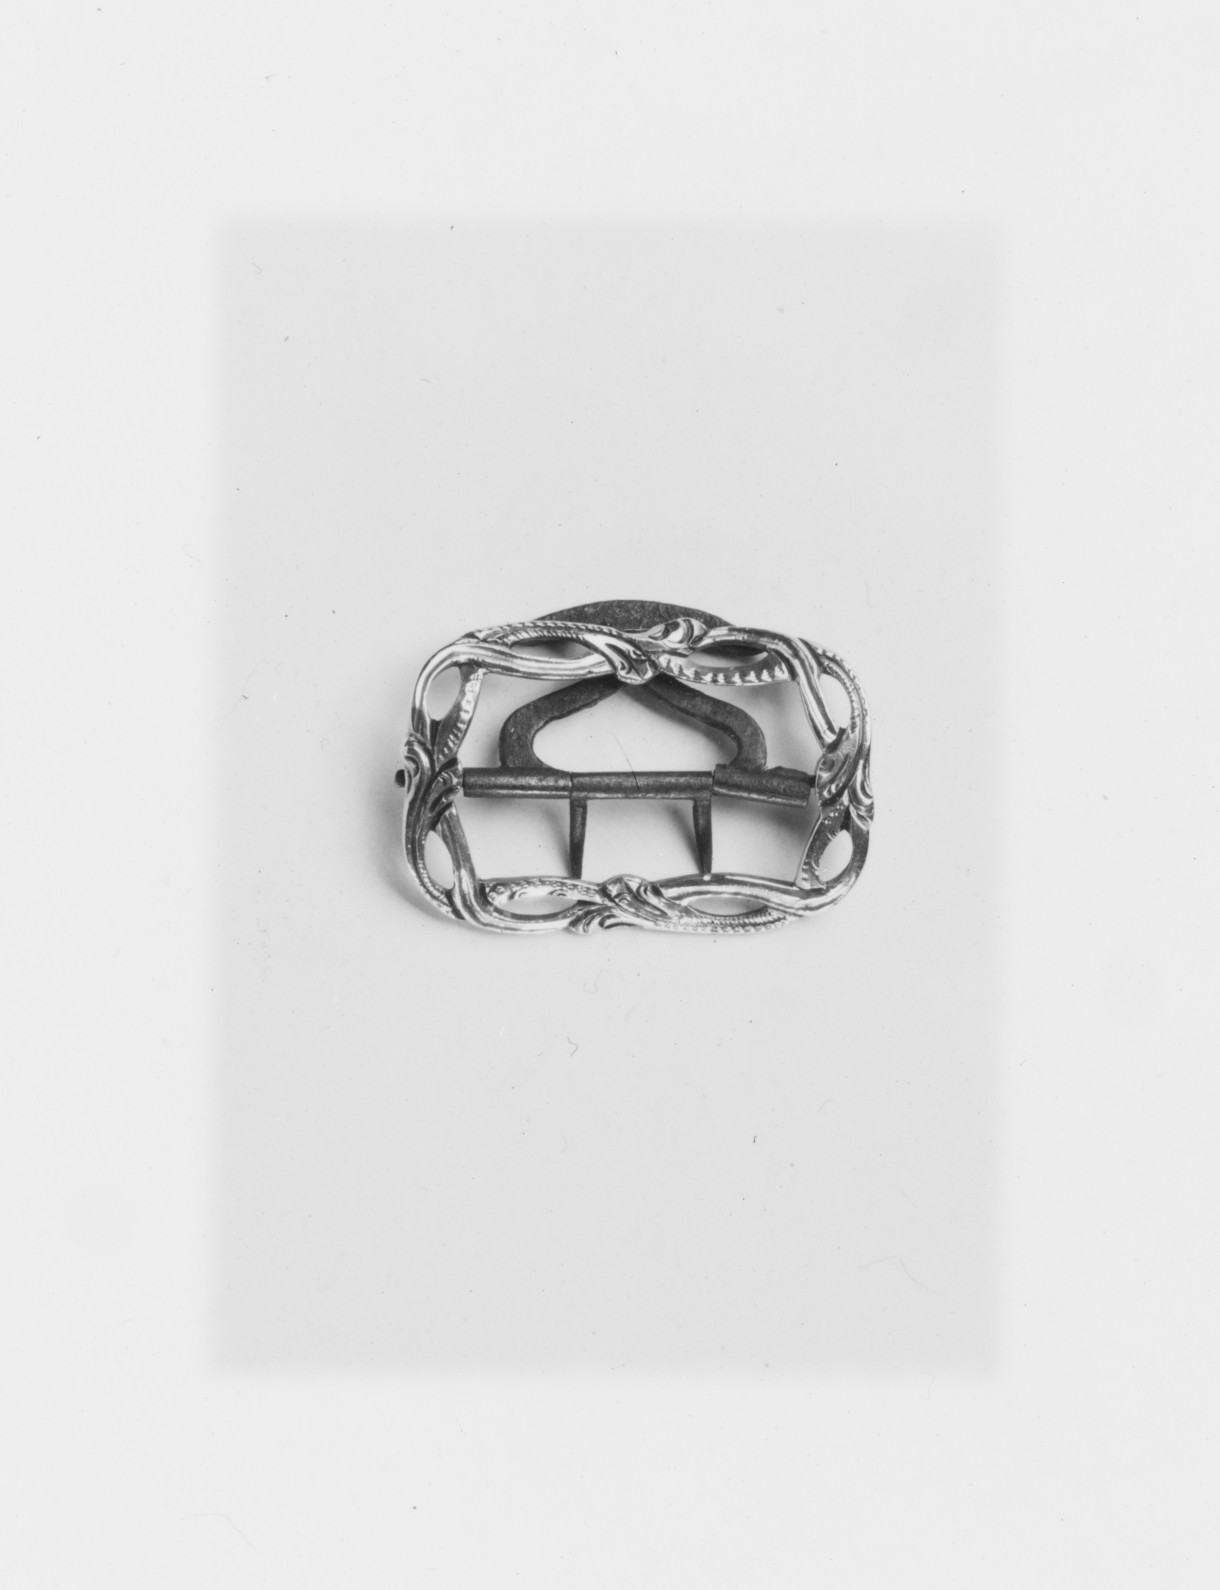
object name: buckle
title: Knee Buckle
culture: american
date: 1730-1775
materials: silver